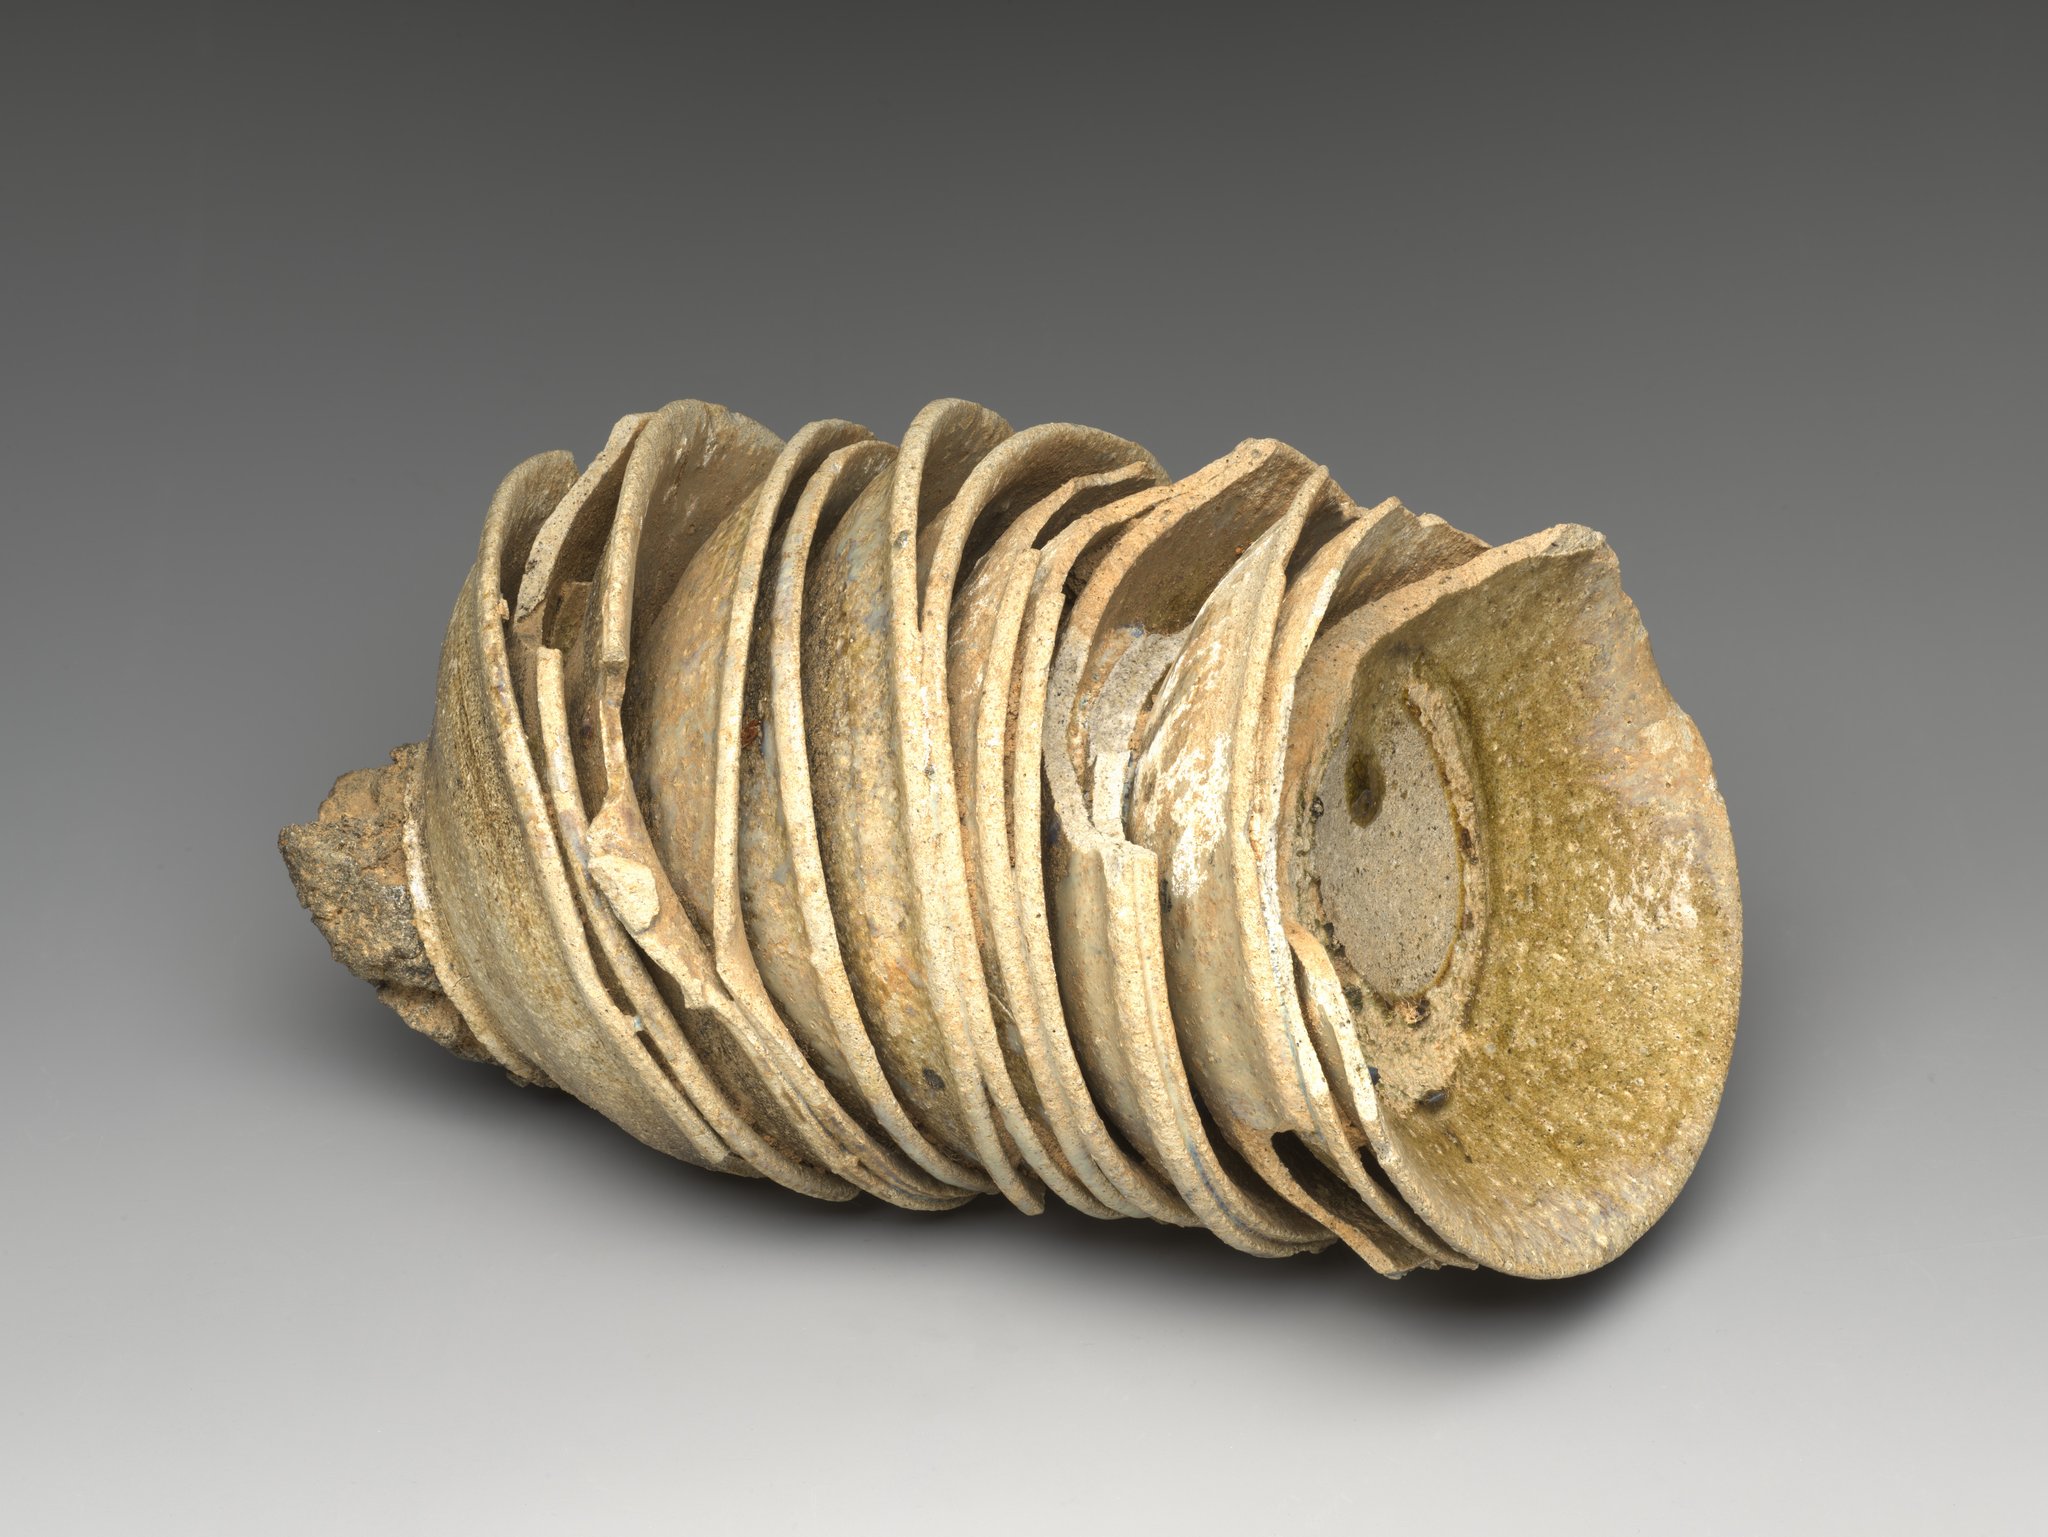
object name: cluster of tea bowl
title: Cluster of mountain tea bowls (yama-chawan)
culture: japanese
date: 1201-1300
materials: wood, glaze, stoneware